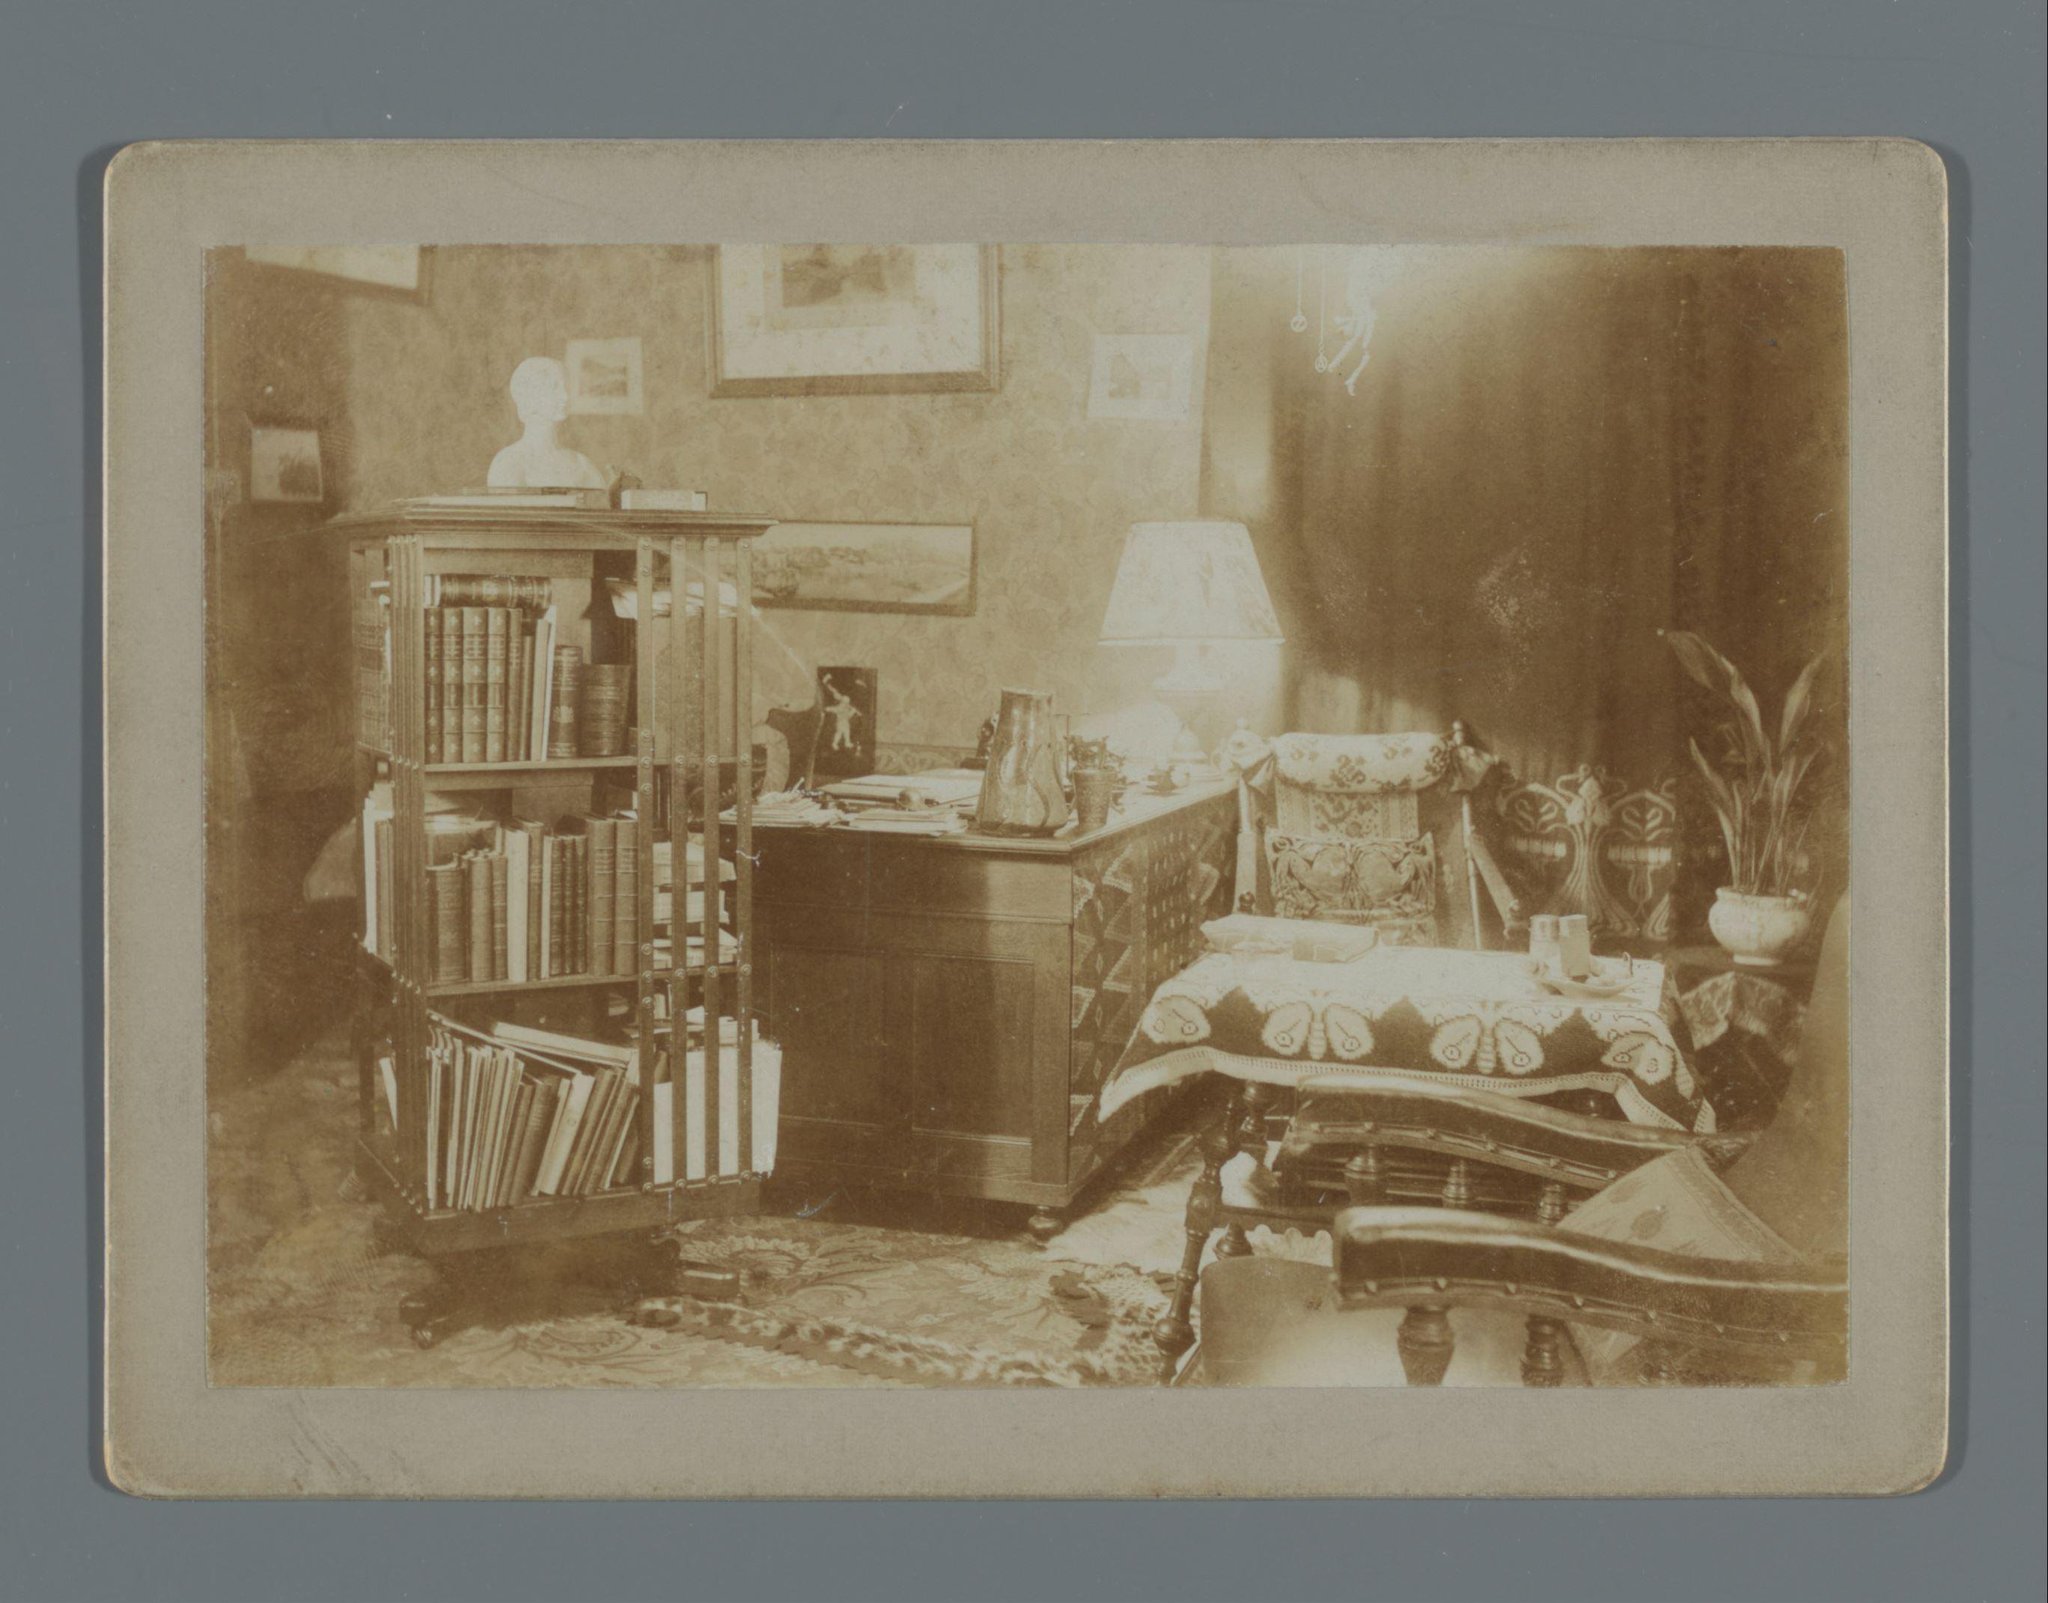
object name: photograph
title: De kamer van Henk van de Berg op de Turfmarkt 3 in Amsterdam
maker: hendrik herman van den berg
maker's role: amateurfotograaf, jurist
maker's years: 1875-1944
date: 1896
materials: cardboard, photographic support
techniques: gelatin silver print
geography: amsterdam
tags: rotterdam, amsterdam, norbertus petrus van den berg (1831-1917), interior of the house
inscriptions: annotation: ‘Mijn kamer op de Turfmarkt’